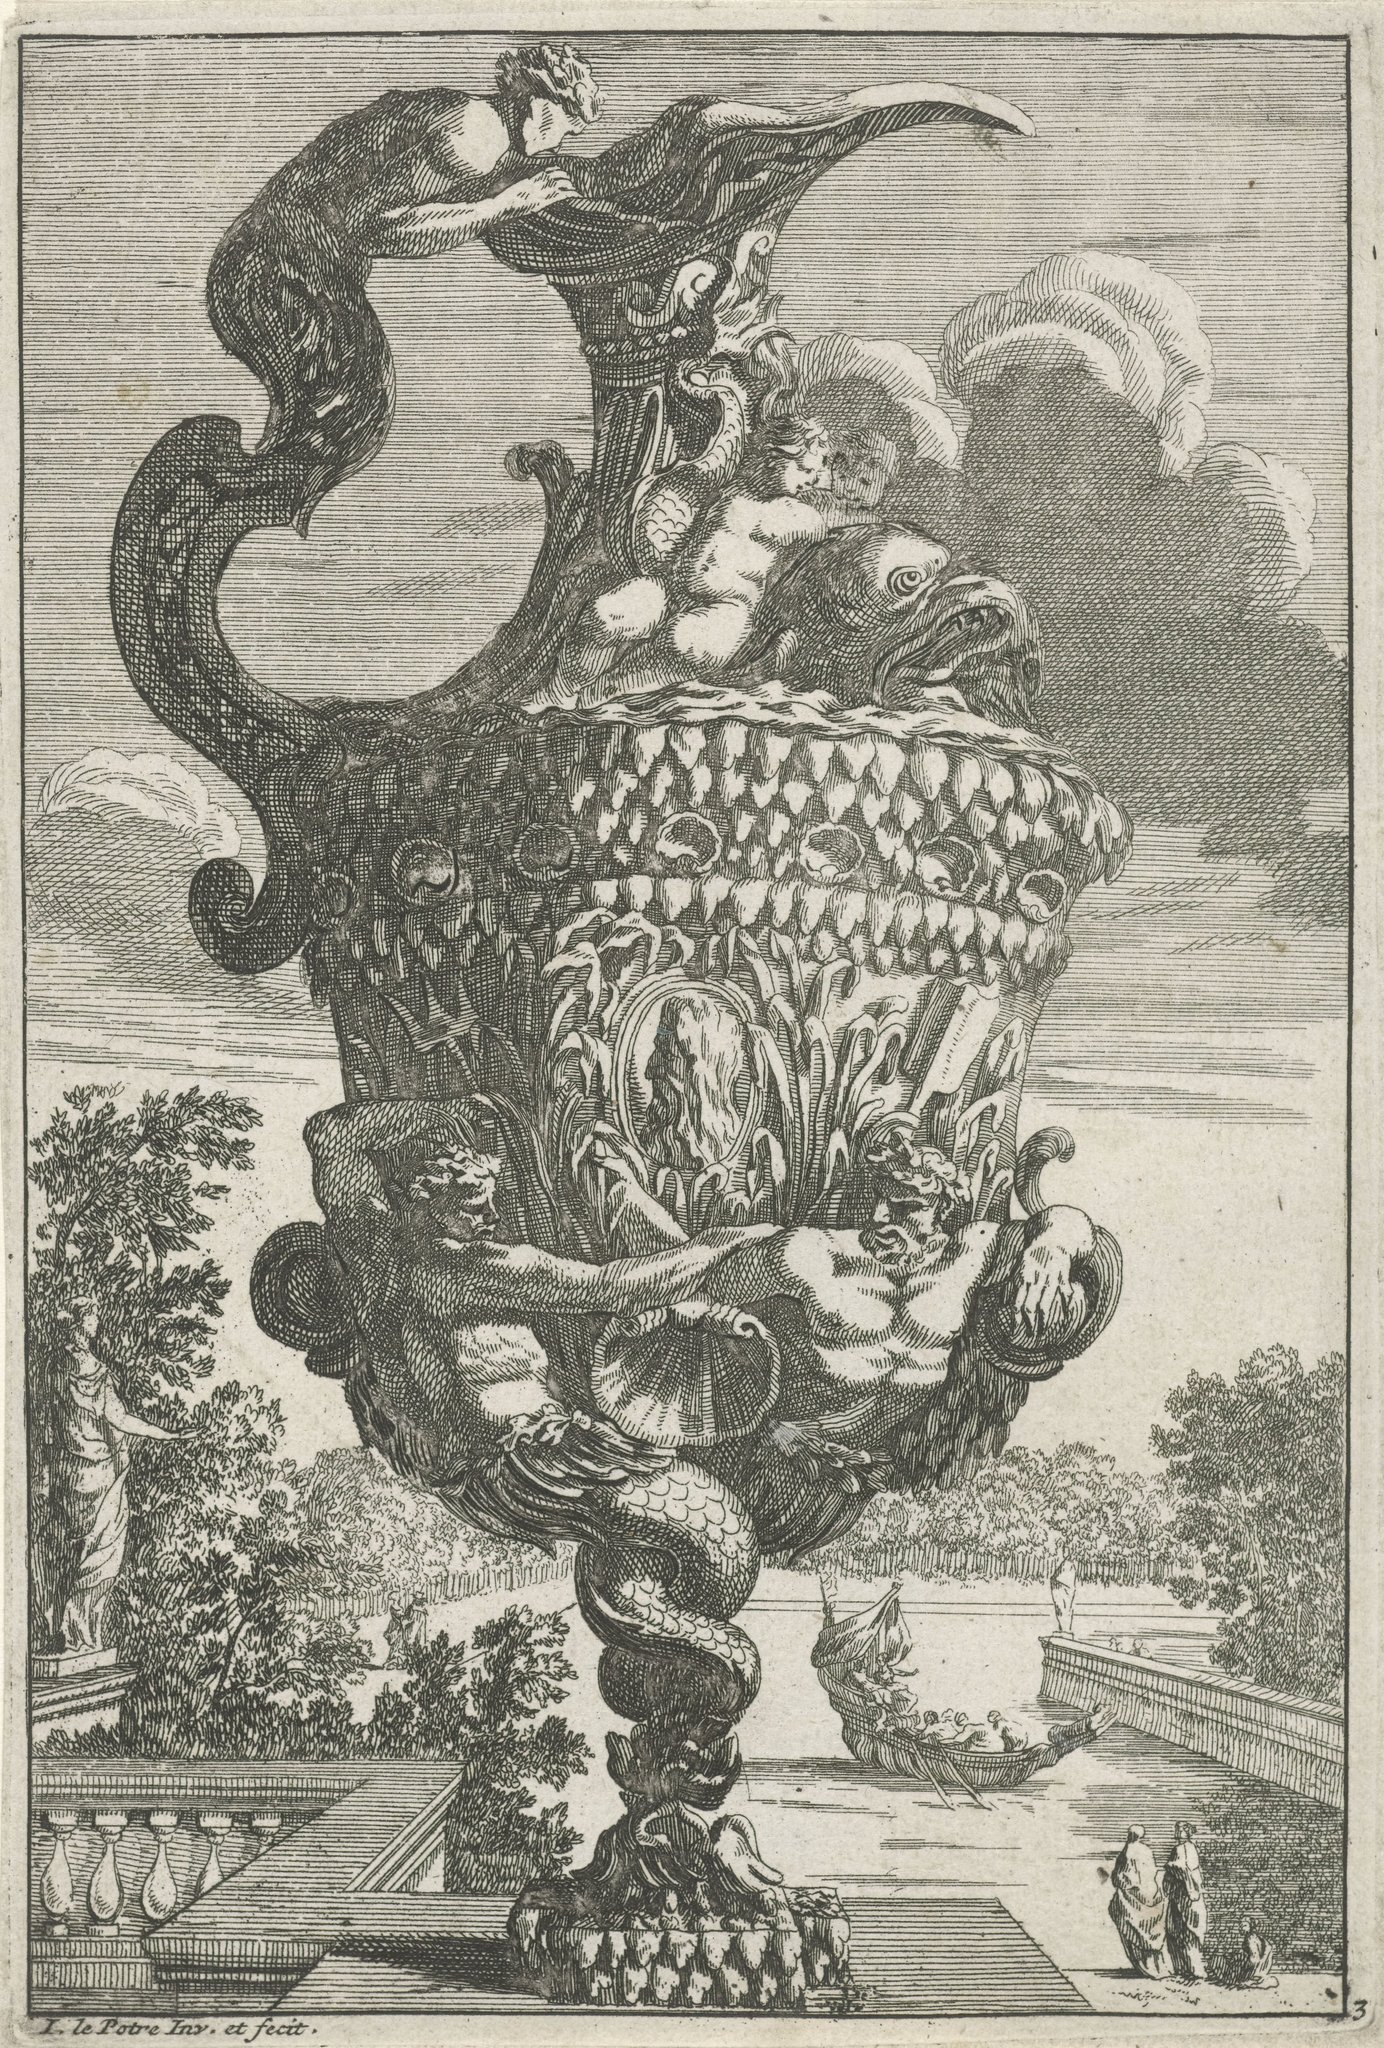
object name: print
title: Portraicture de Diverses Vases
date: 1628-1732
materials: paper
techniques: etching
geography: france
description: Het handvat wijst naar links, op de achtergrond zijn een tuin en een kanaal zichtbaar.